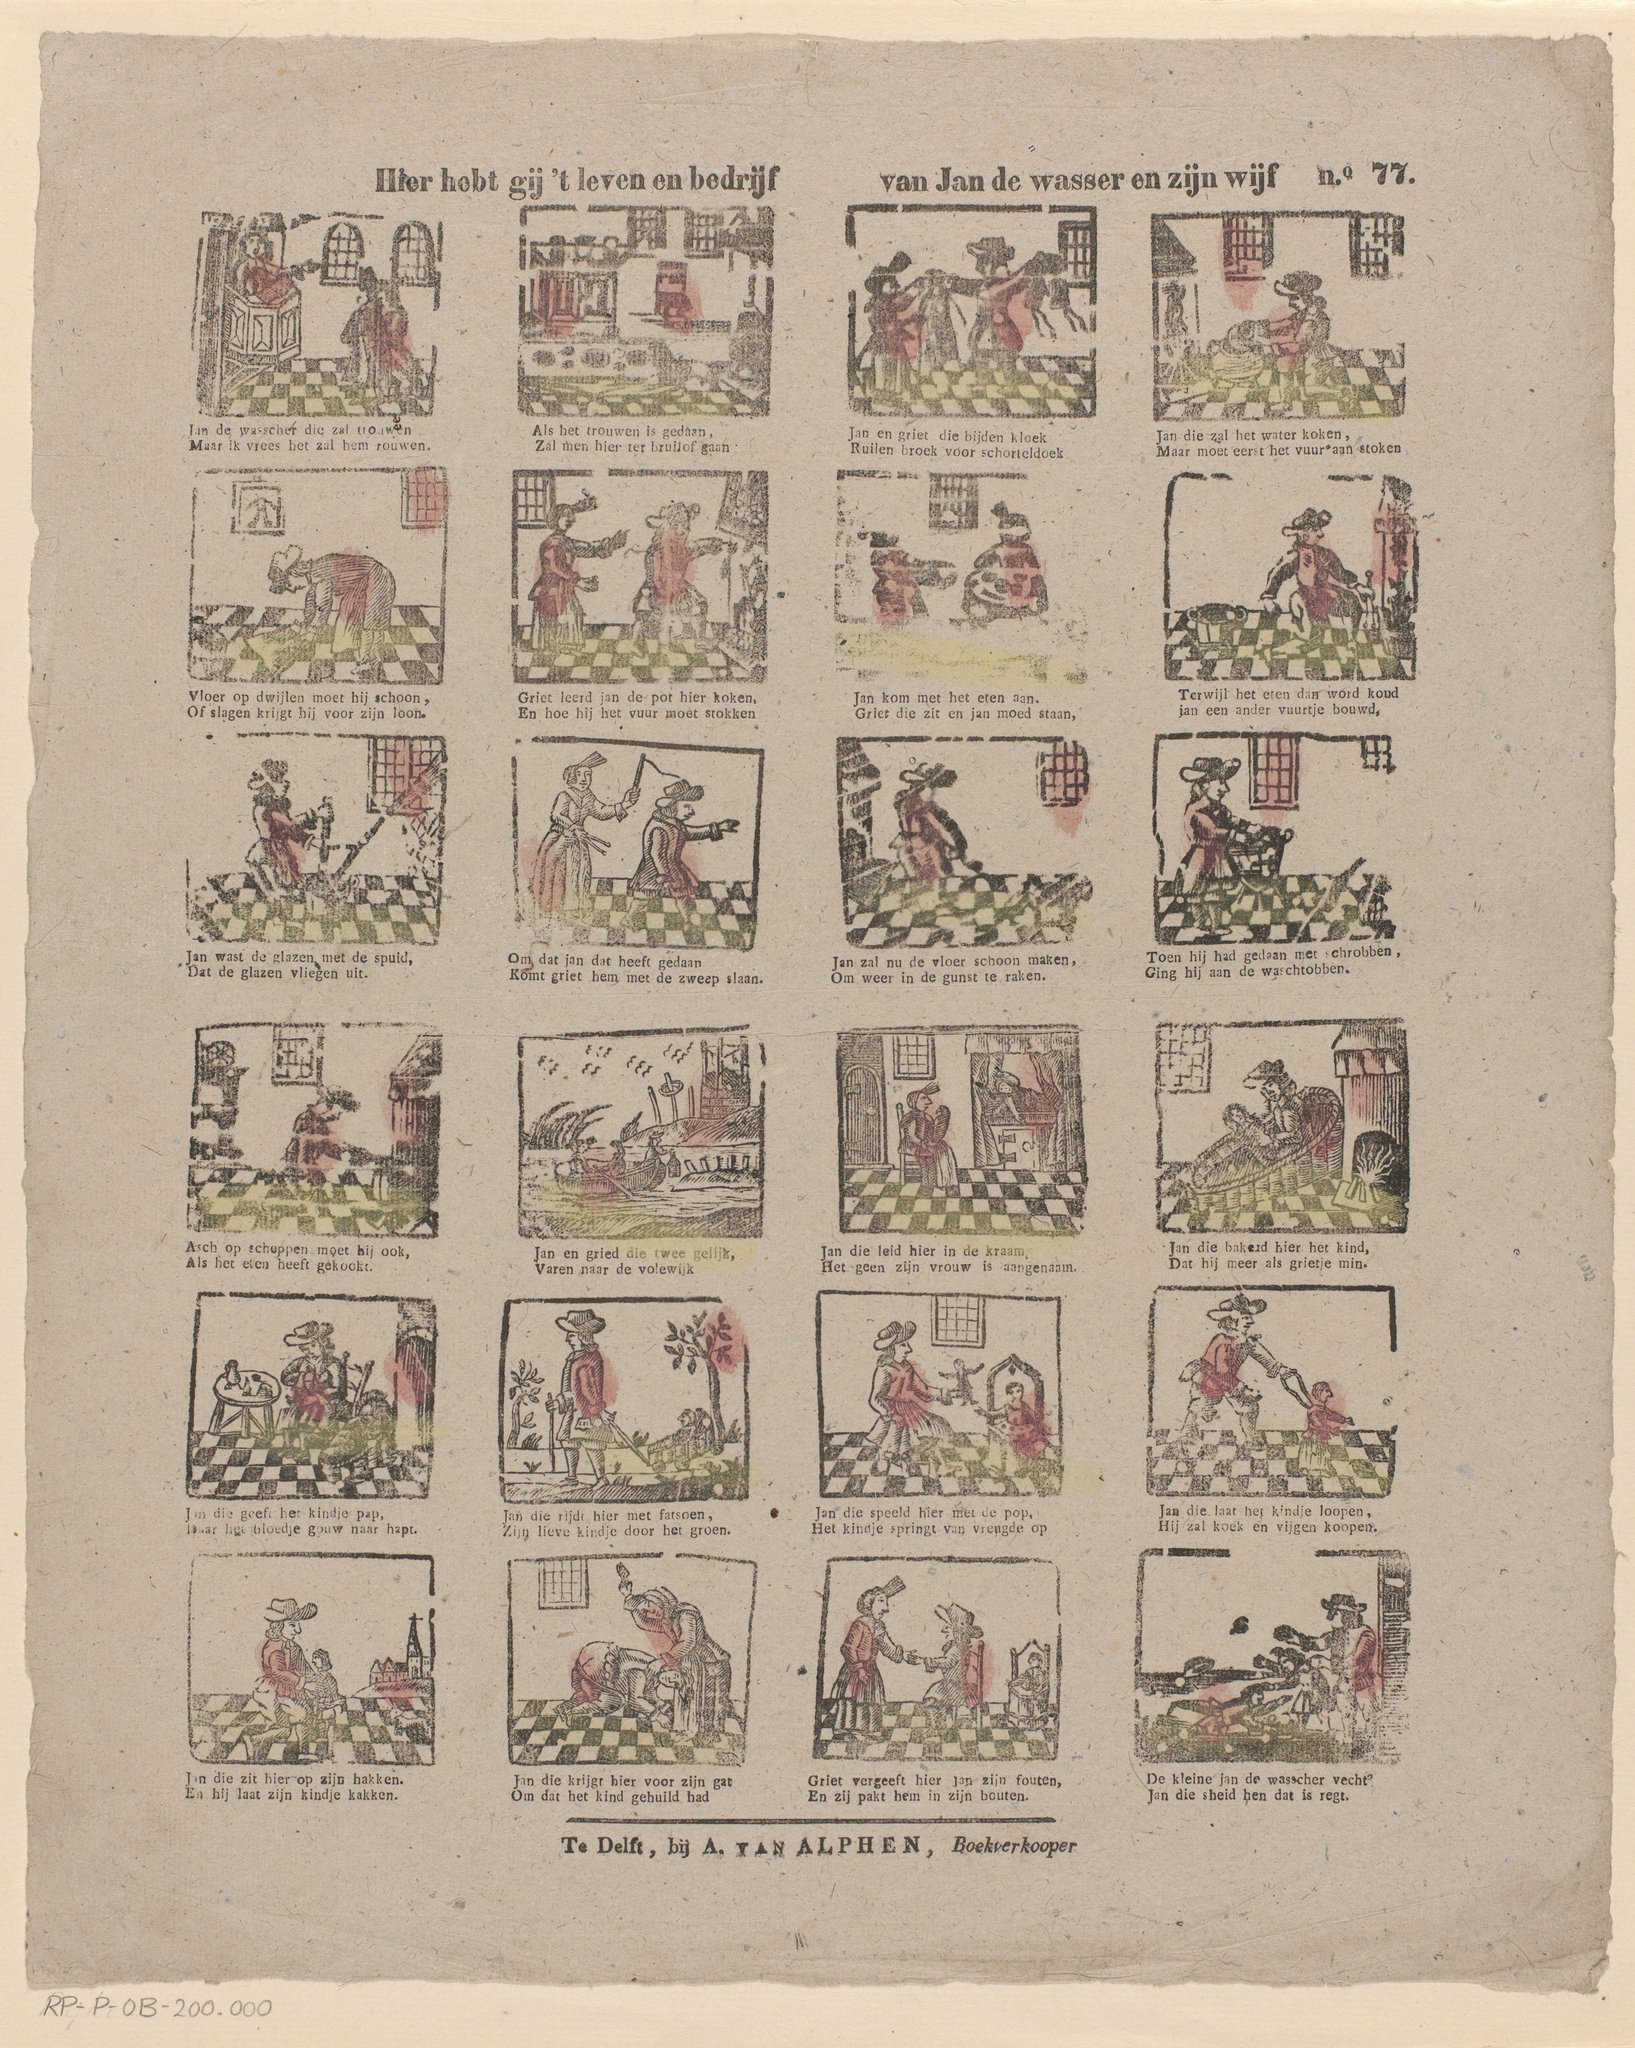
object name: popular print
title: Hier hebt gij 't leven en bedrijf van Jan de Wasser en zijn wijf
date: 1827-1866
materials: paper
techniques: colour, letterpress printing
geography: delft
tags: battle for dominance in marriage ('who wears the breeches'), pulpit, ambo, chancel, cradle, crib, whip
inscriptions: collector's mark: Lugt 2760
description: Blad met 24 voorstellingen uit het leven van Jan de Wasser, een man die van zijn vrouw Griet, die de broek aan heeft, al het huishoudelijk werk moet doen. Onder elke afbeelding een tweeregelig vers. Genummerd rechtsboven: No. 77.